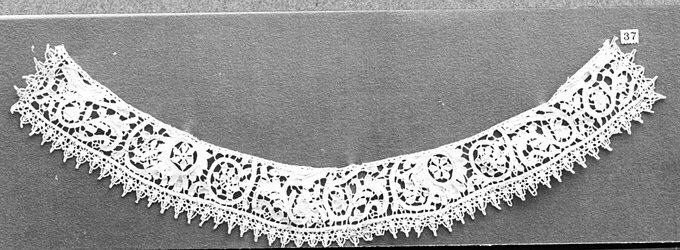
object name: collar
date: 1601-1700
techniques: lace